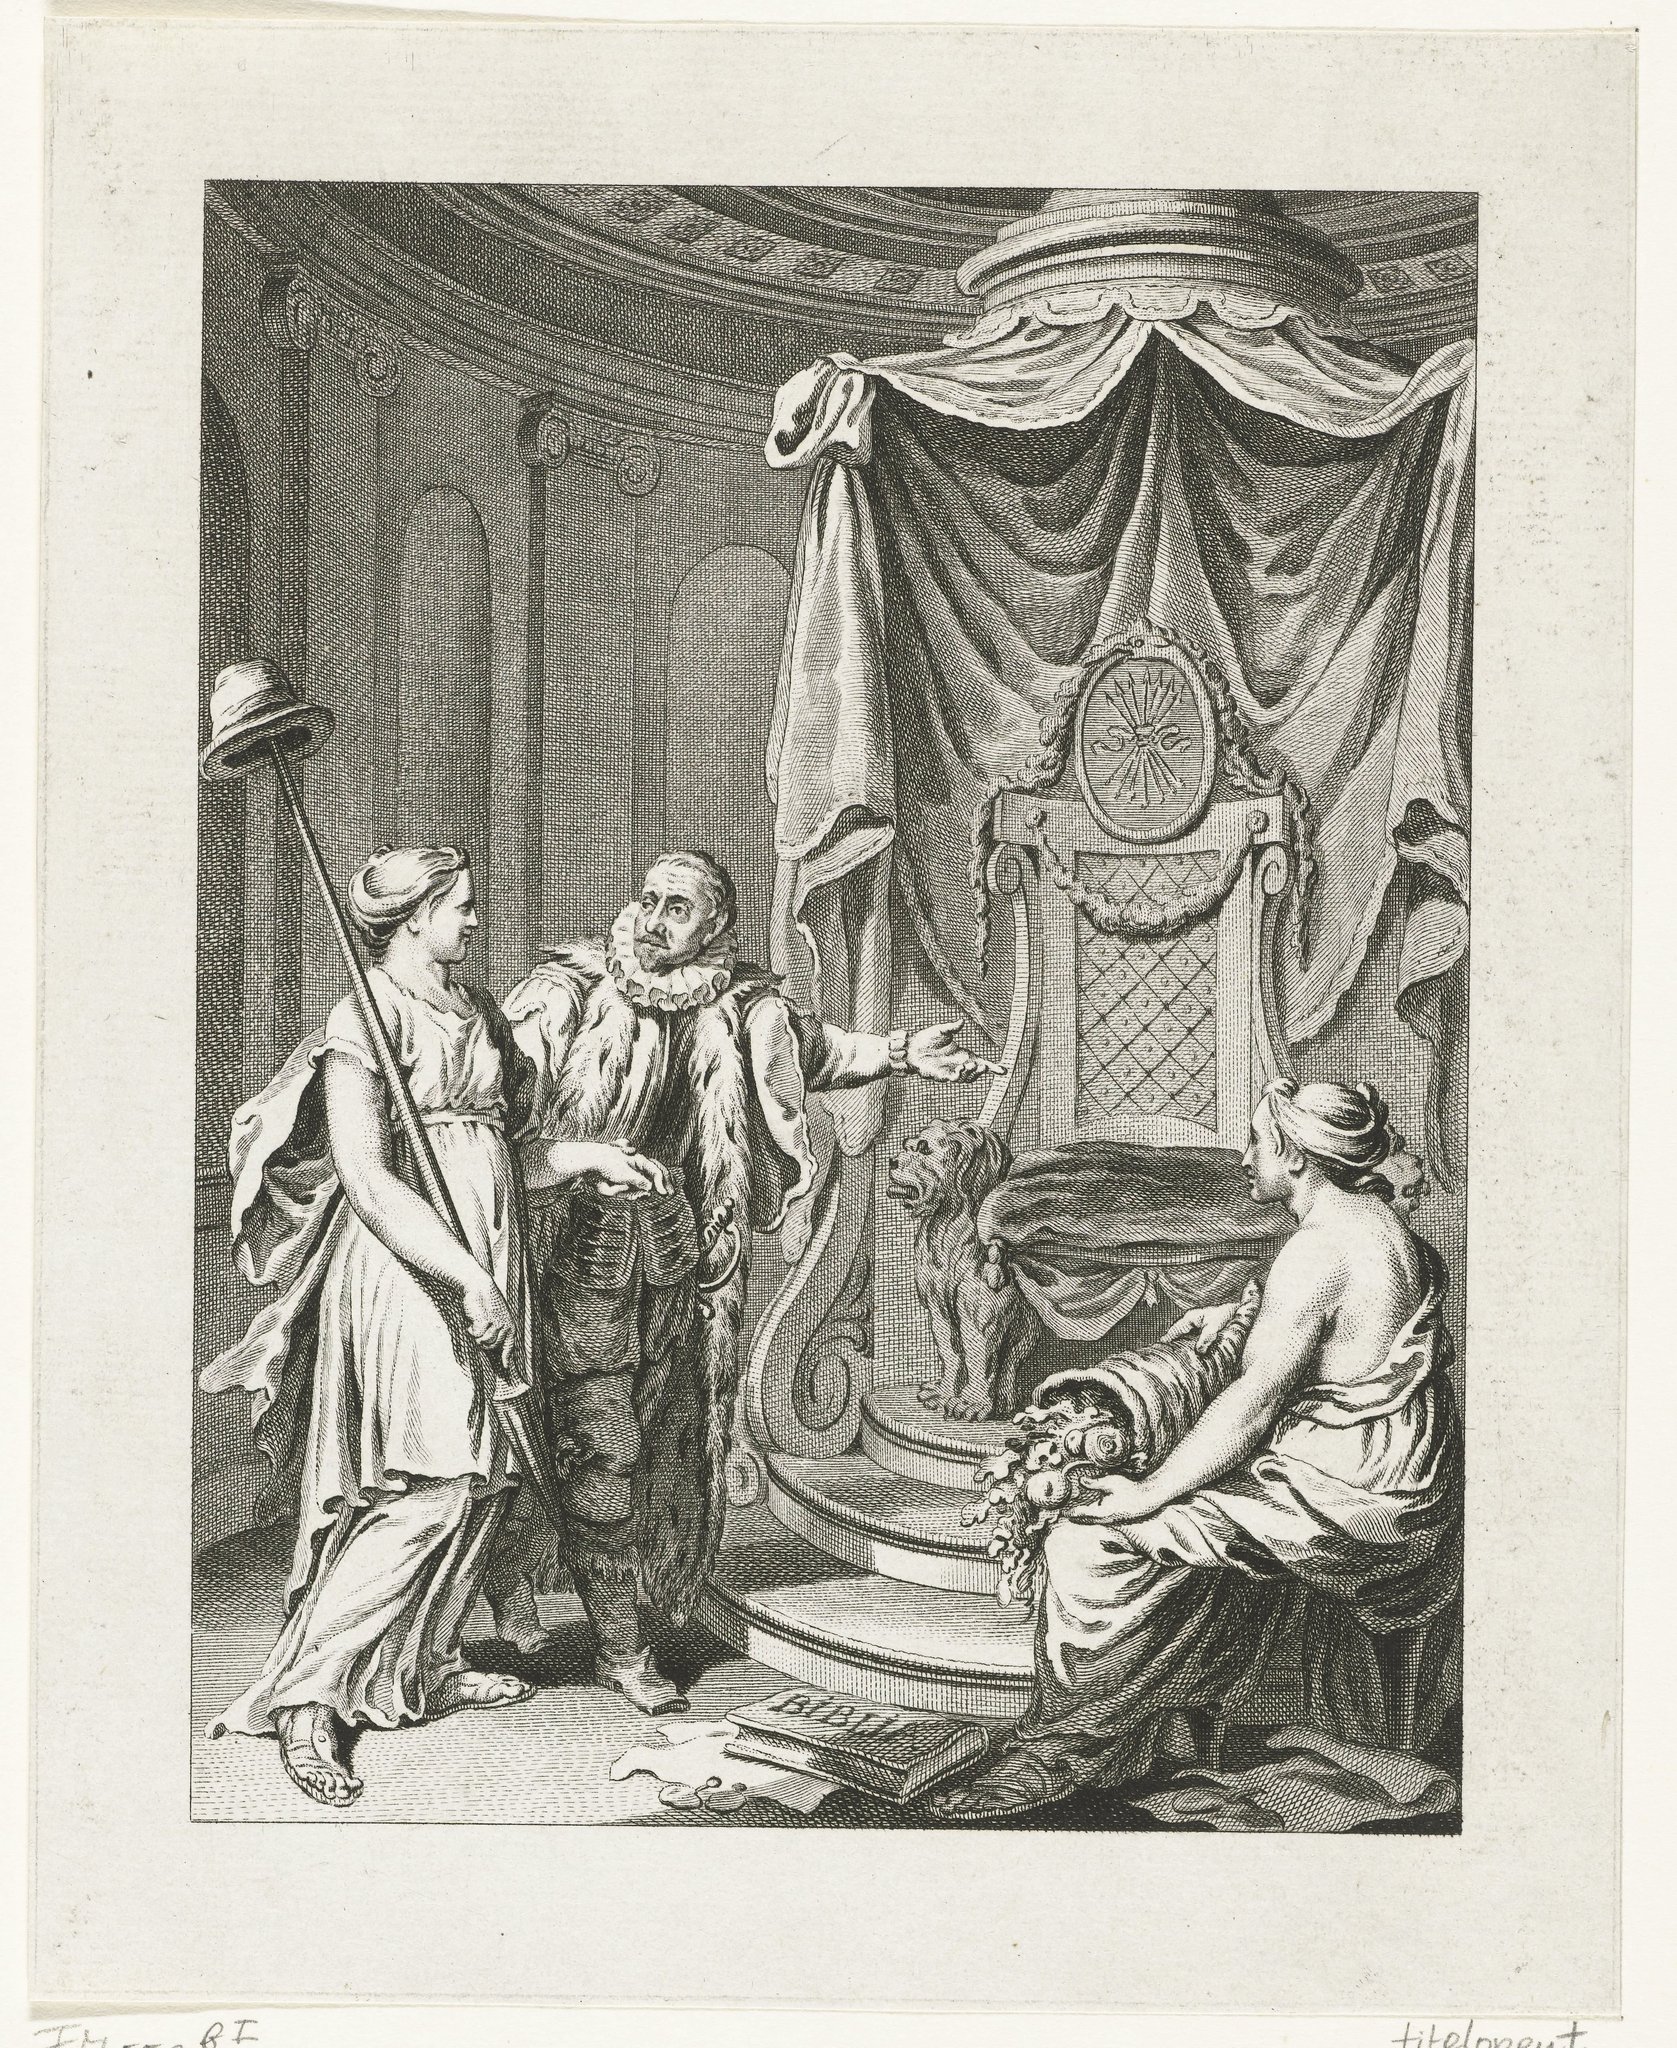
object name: print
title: Titelplaat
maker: cornelis brouwer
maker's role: print maker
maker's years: 1731-1803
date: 1788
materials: paper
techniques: etching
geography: northern netherlands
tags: delft, william i (prince of orange), personifications of countries, nations, states, districts, etc., netherlands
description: Illustratie voor: J. Nomsz, Willem de eerste, of de grondlegging der Nederlandsche vryheid. : In vier en twintig zangen, Erven van David Klippink, Amsterdam 1779. Staat vóór de letter.